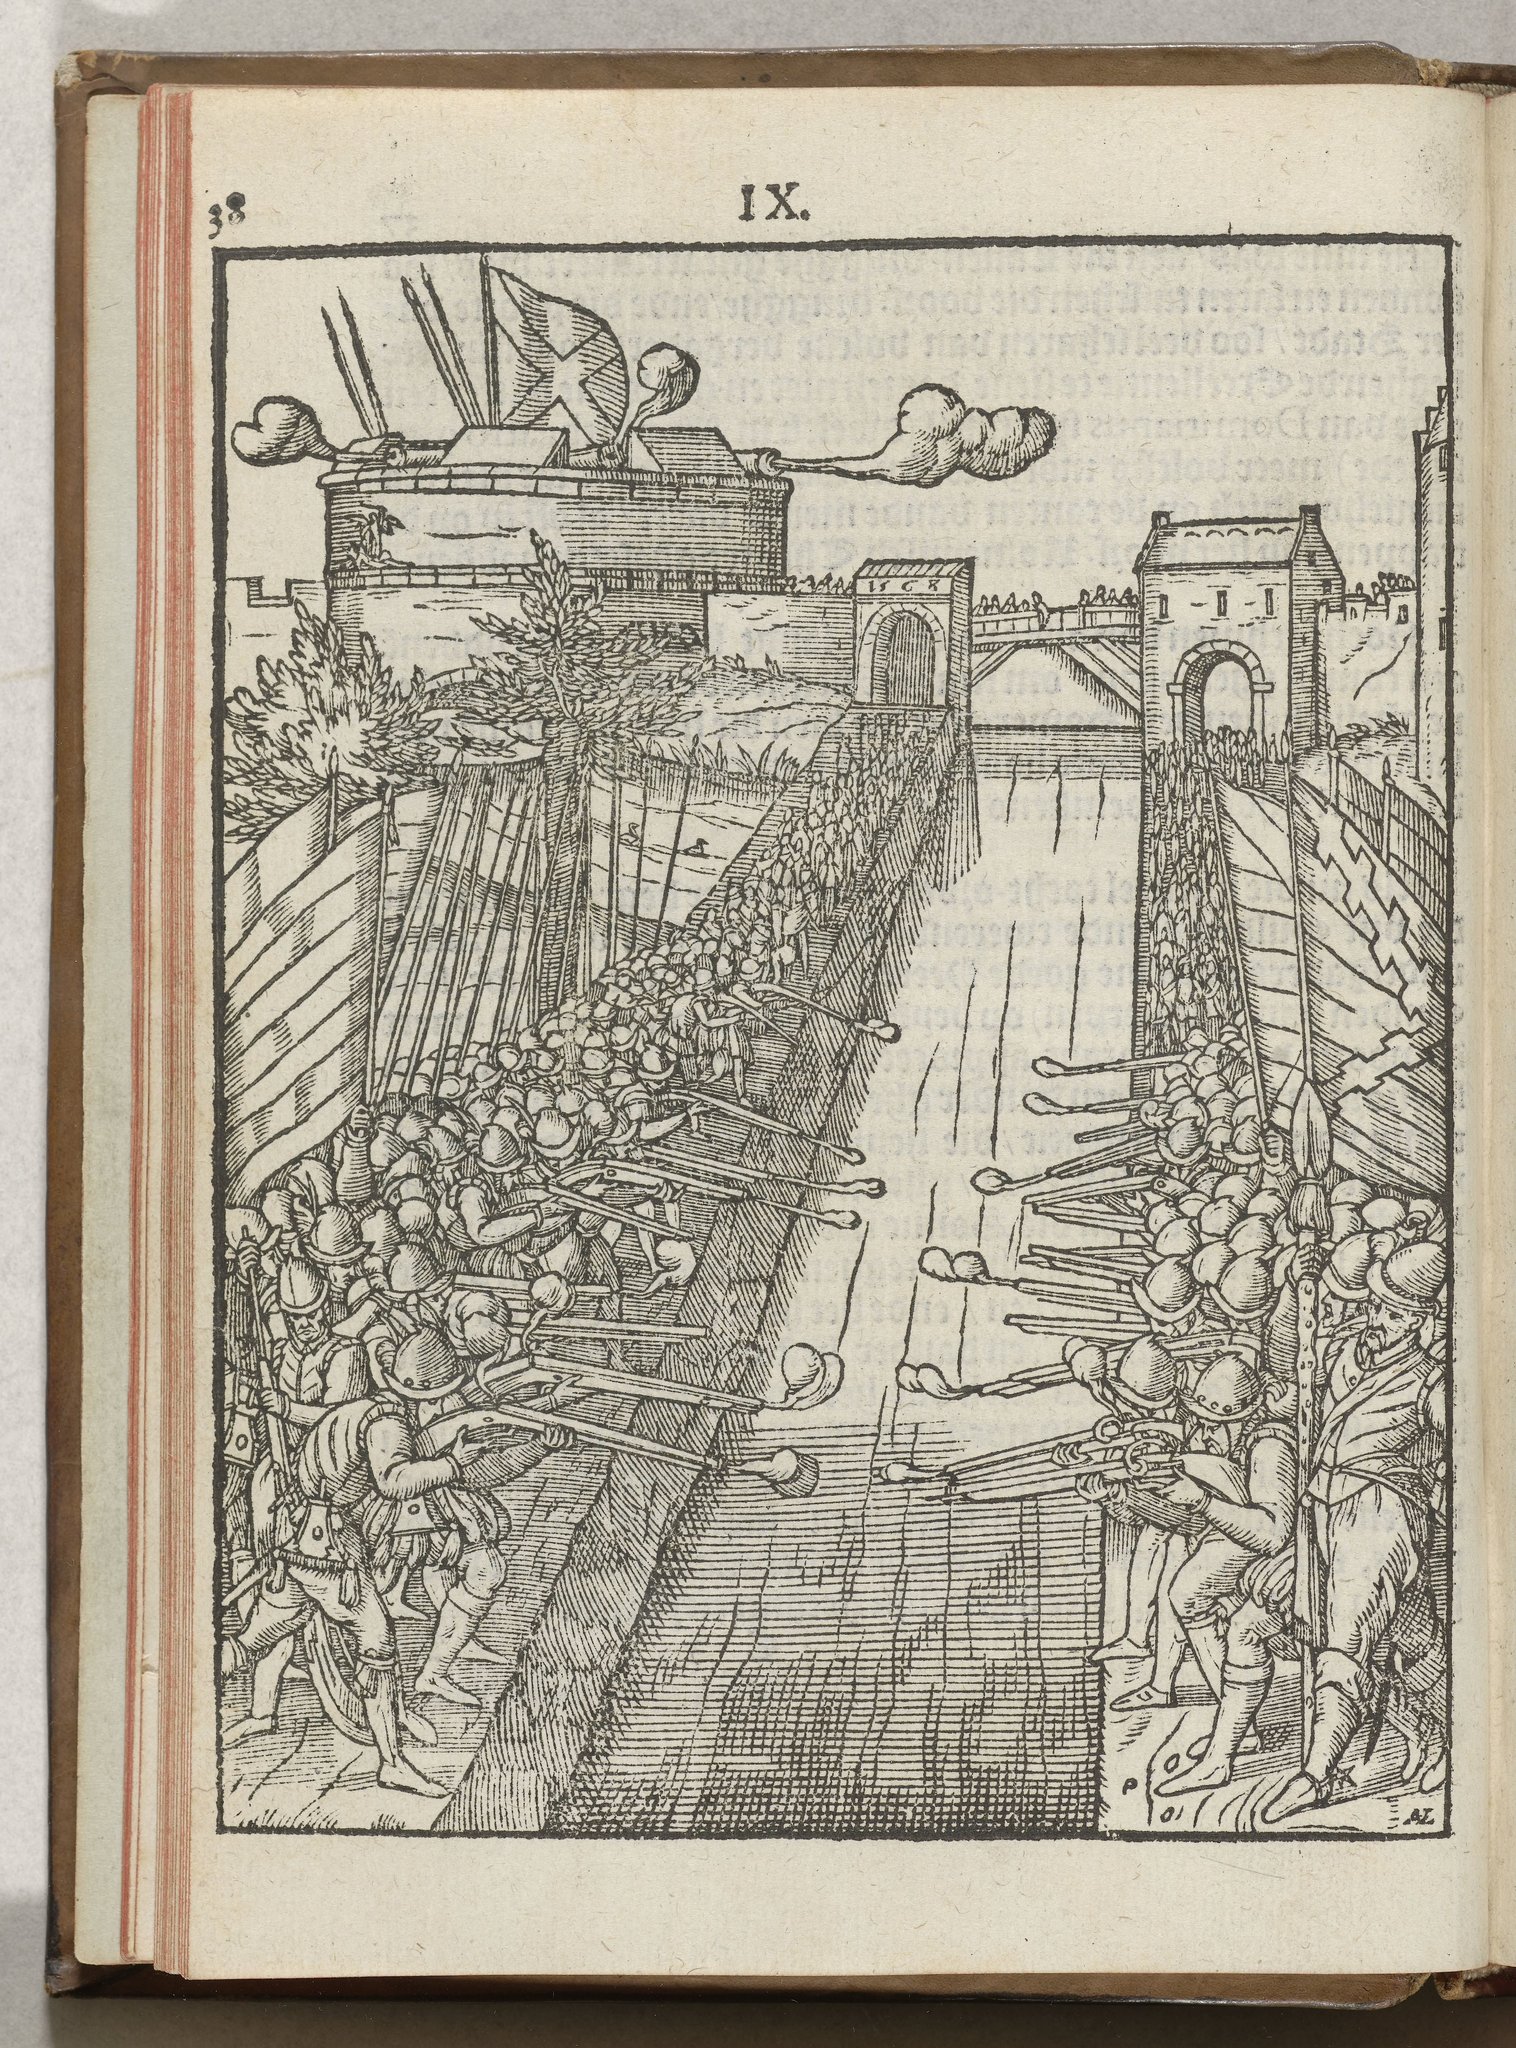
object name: print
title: Langs de vaart opgestelde en vurende gilden van Brussel en Antwerpen en de wijken van Brussel, 1577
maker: antoni van leest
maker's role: print maker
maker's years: 1545-1592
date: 1577-1578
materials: paper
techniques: woodcut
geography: netherlands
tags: delft, william i (prince of orange), ruler saluted with gun-fire, triumphal entry and public reception, pageant, 'entrée solennelle', 'joyeuse entrée', brussels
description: Illustratie in: J. B. Houwaert, Declaratie van die triumphante incompst vande doorluchtighen ende hoogheboren Prine van Oraingnien, binnen die princelijcke stadt van Brussele, geschiet in t' iaer ... 1578, den 18 Septembris, Christoffel Plantijn, Antwerpen 1579. Boek in de bibliotheek met signatuur: 325 D 29.